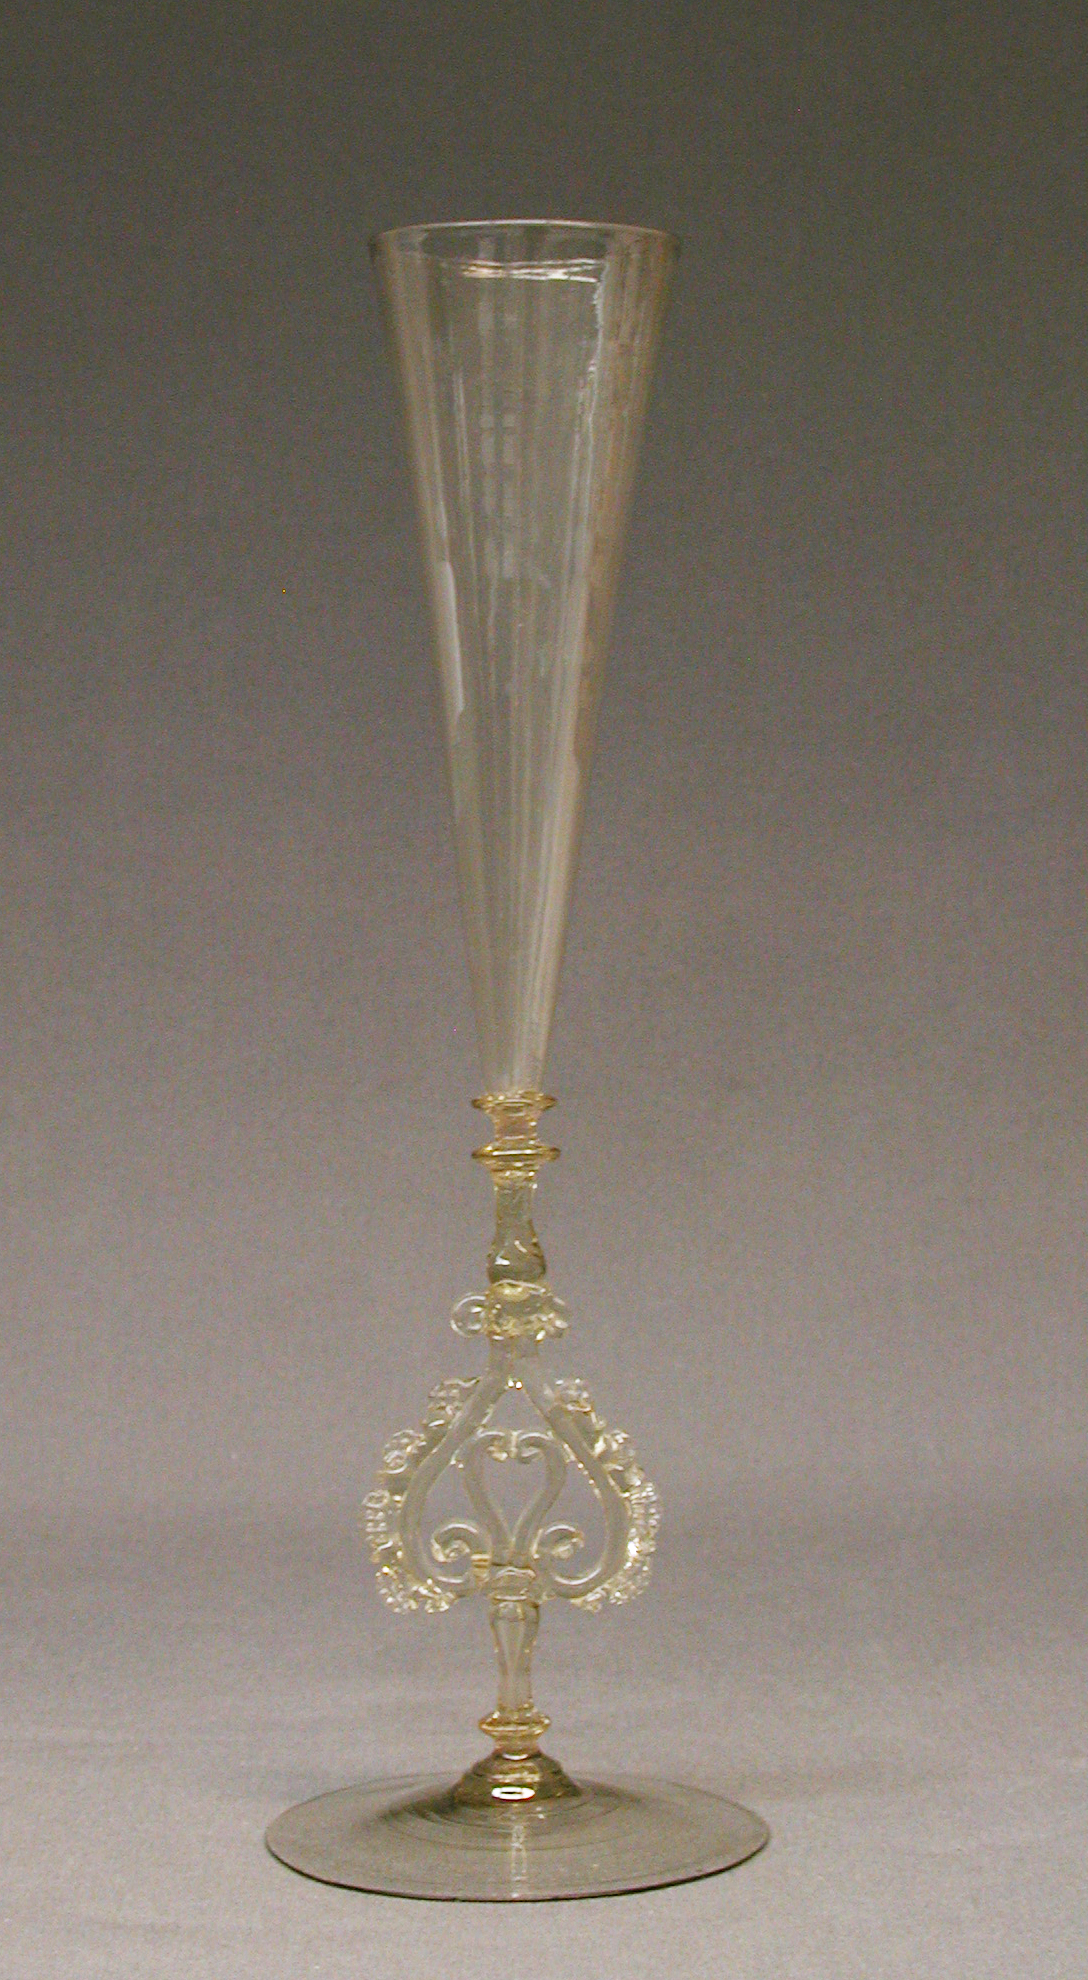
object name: wineglass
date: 1801-1900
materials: glass